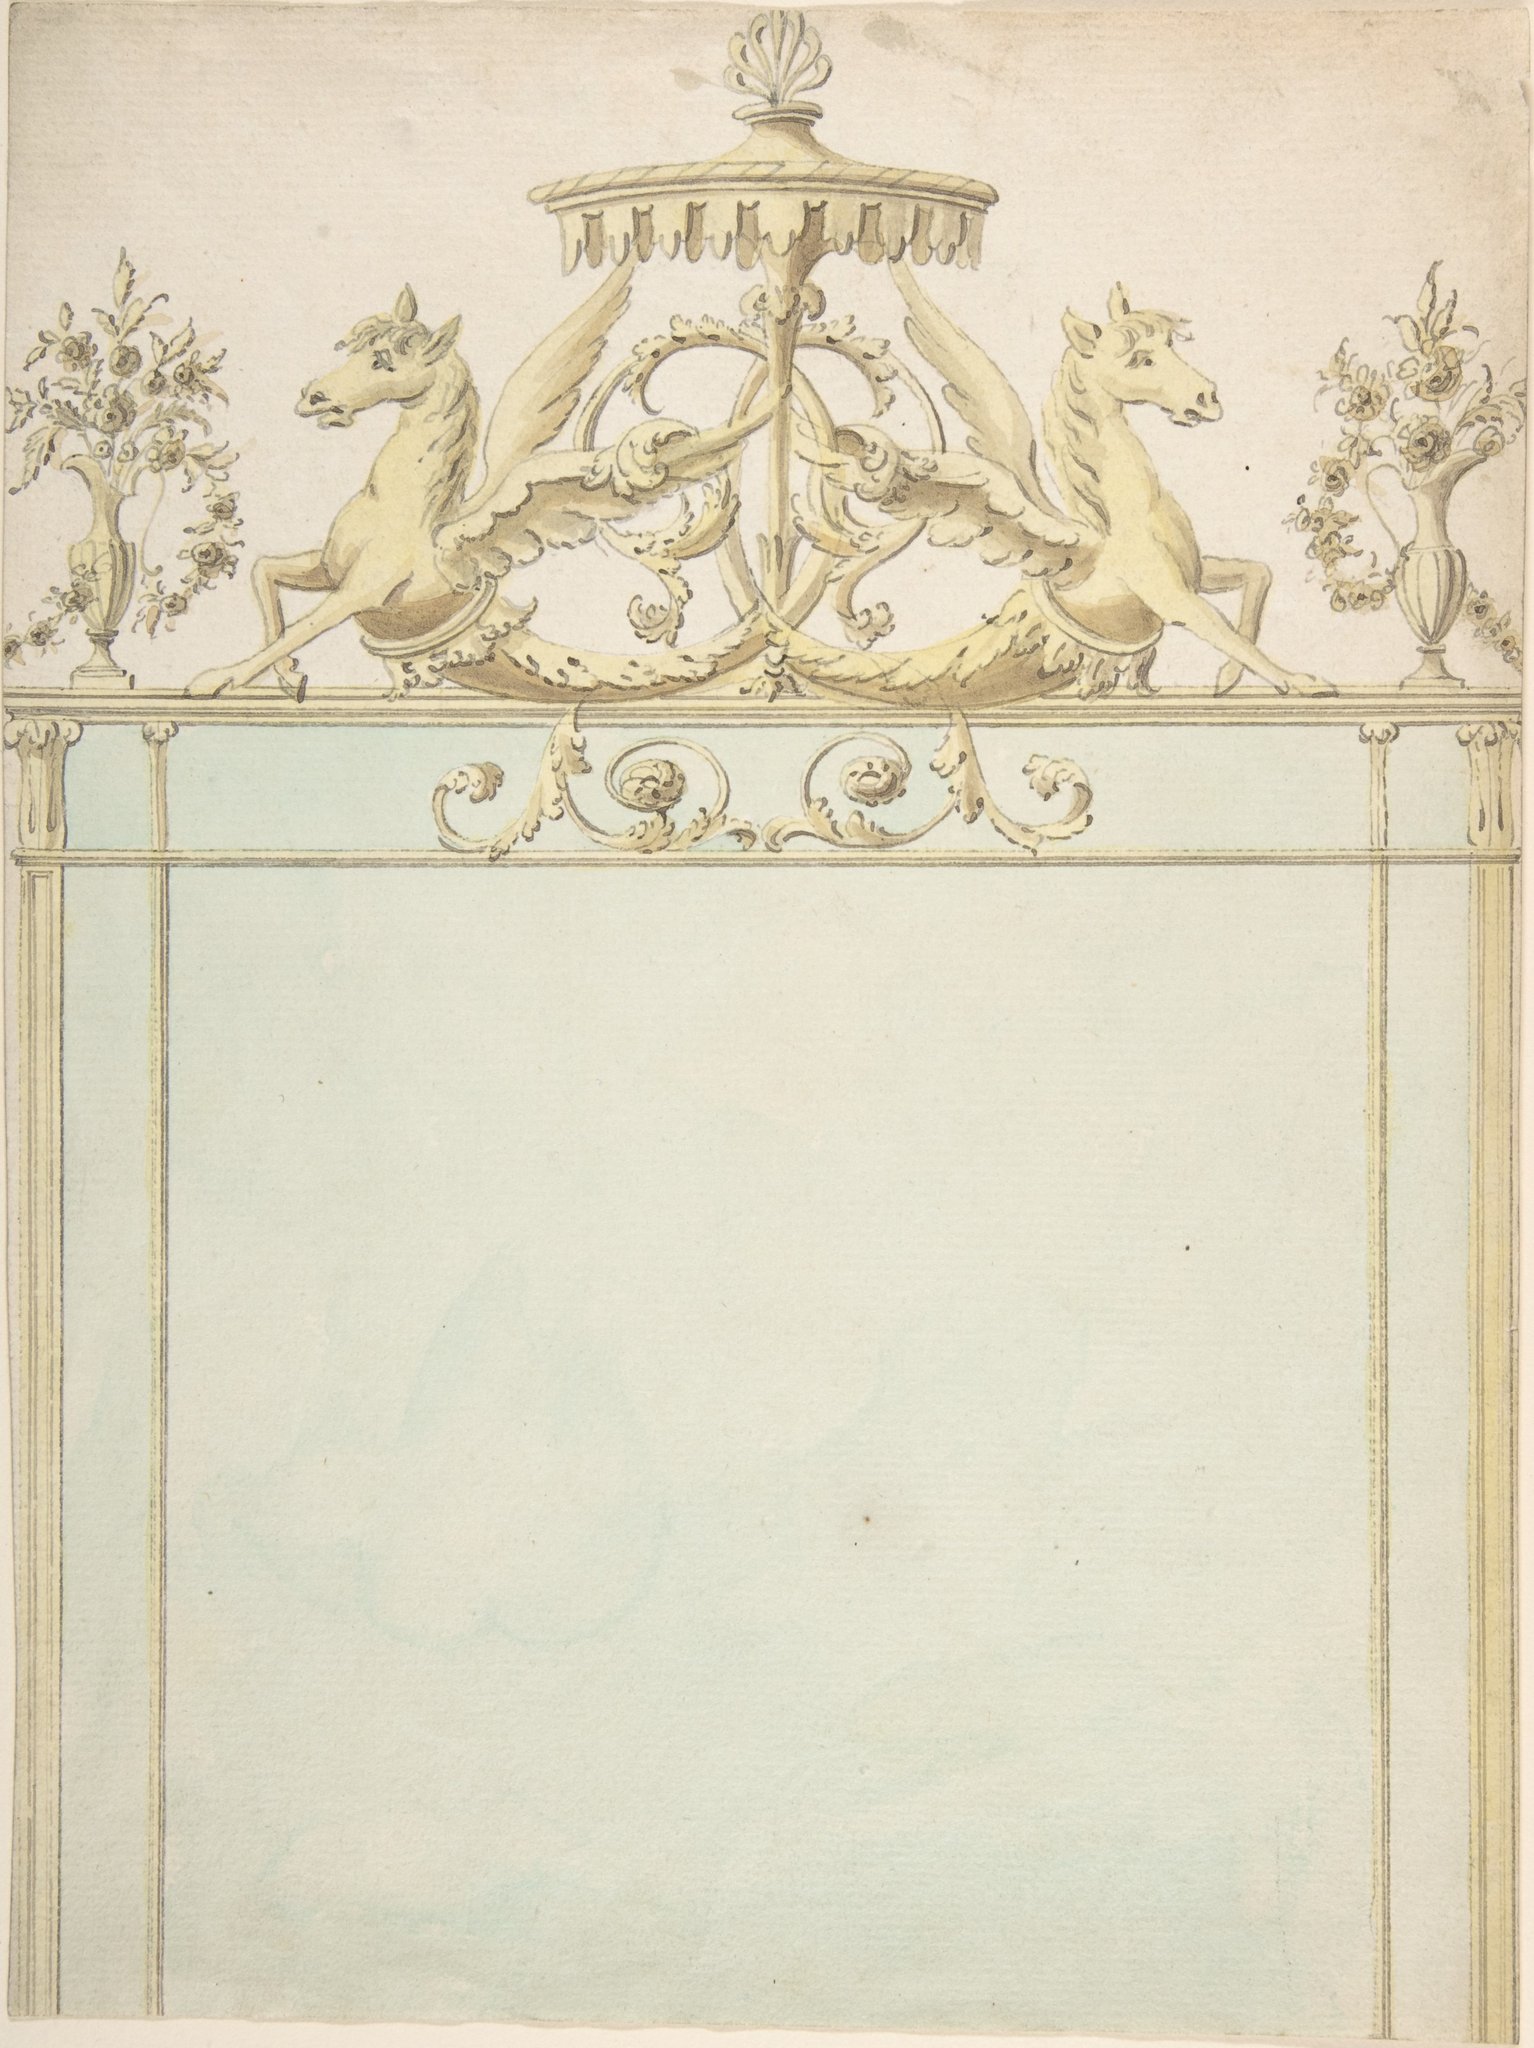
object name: drawing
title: Design for a Mirror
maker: james wyatt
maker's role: artist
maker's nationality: british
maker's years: 1746-1813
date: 1734-1833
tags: pegasus